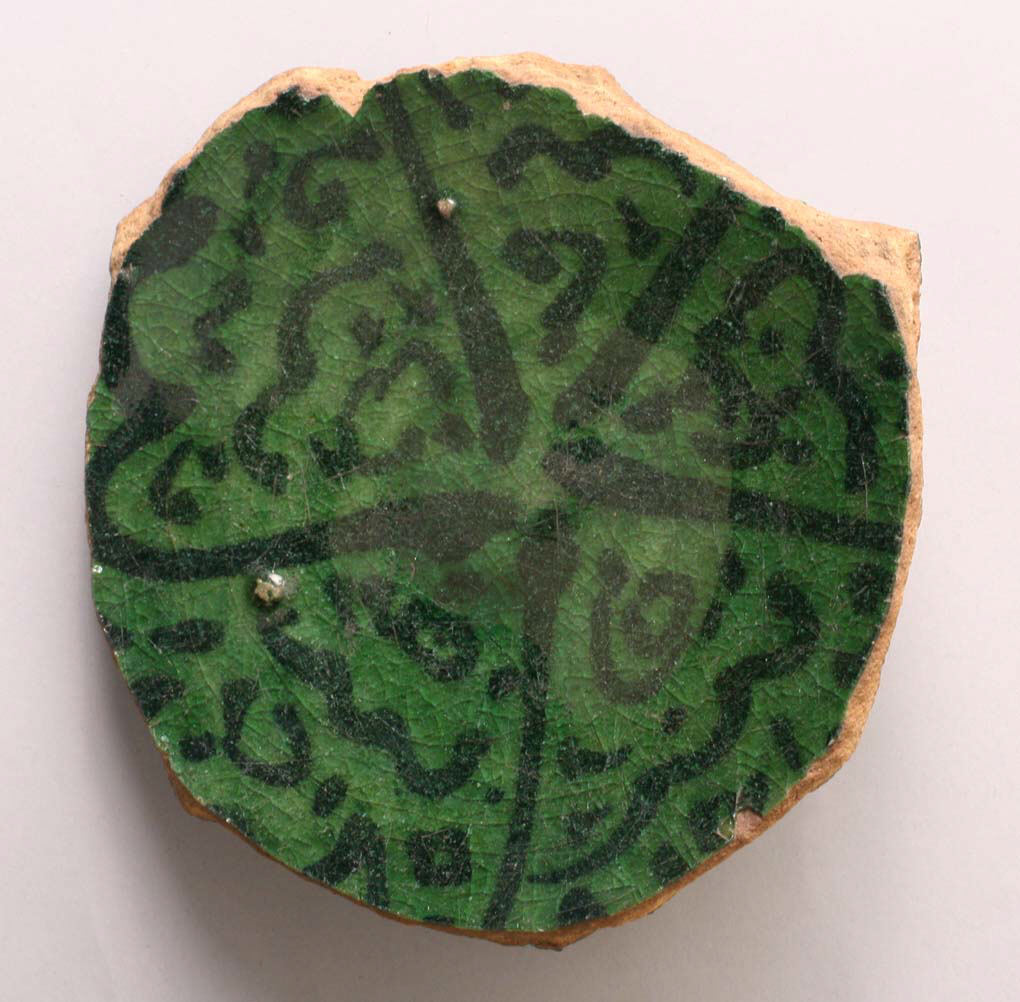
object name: ceramic fragment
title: Fragment of a Bowl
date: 1301-1400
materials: earthenware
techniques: glazing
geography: egypt